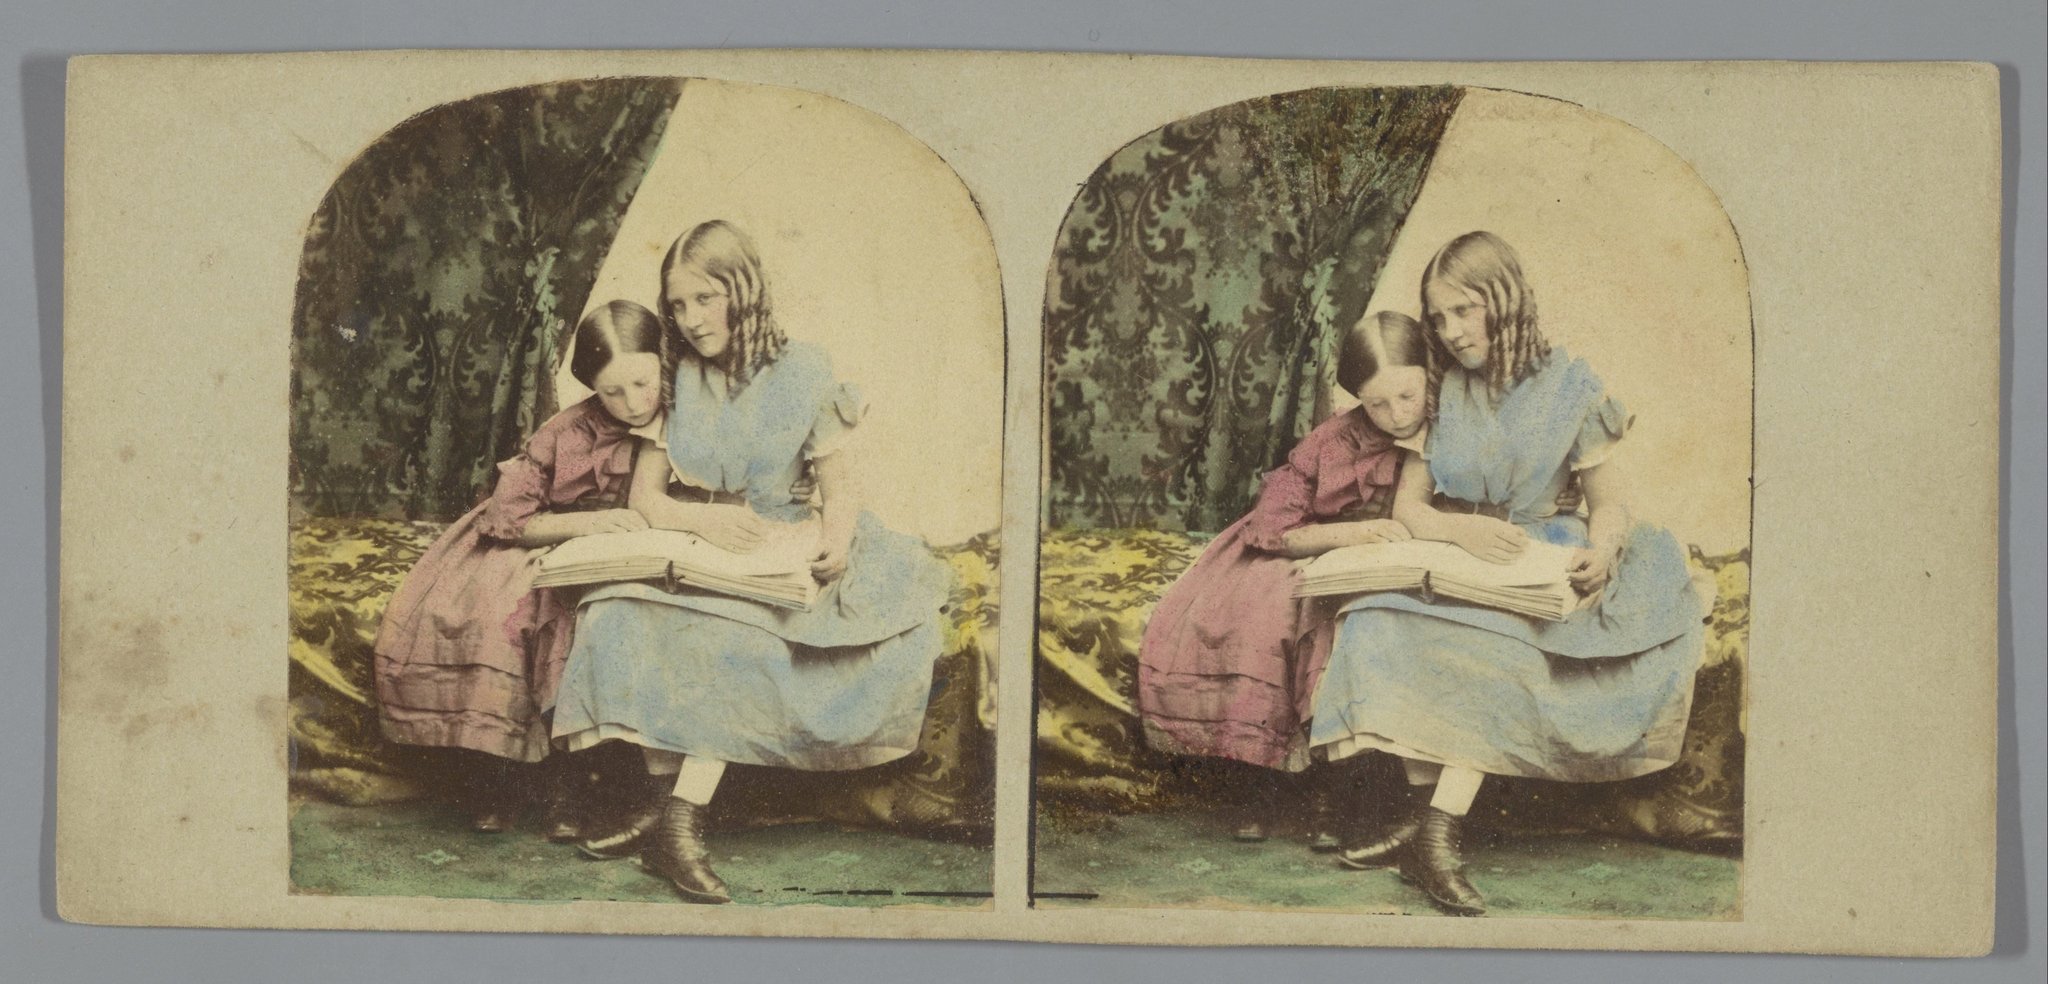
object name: stereograph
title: Twee meisjes met een boek op een bank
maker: Anonymous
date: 1852-1863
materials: cardboard, paper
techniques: albumen print, hand coloring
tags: reading to somebody, child (at home) - aa - girl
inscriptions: inscription: ‘W: K: W: N:’